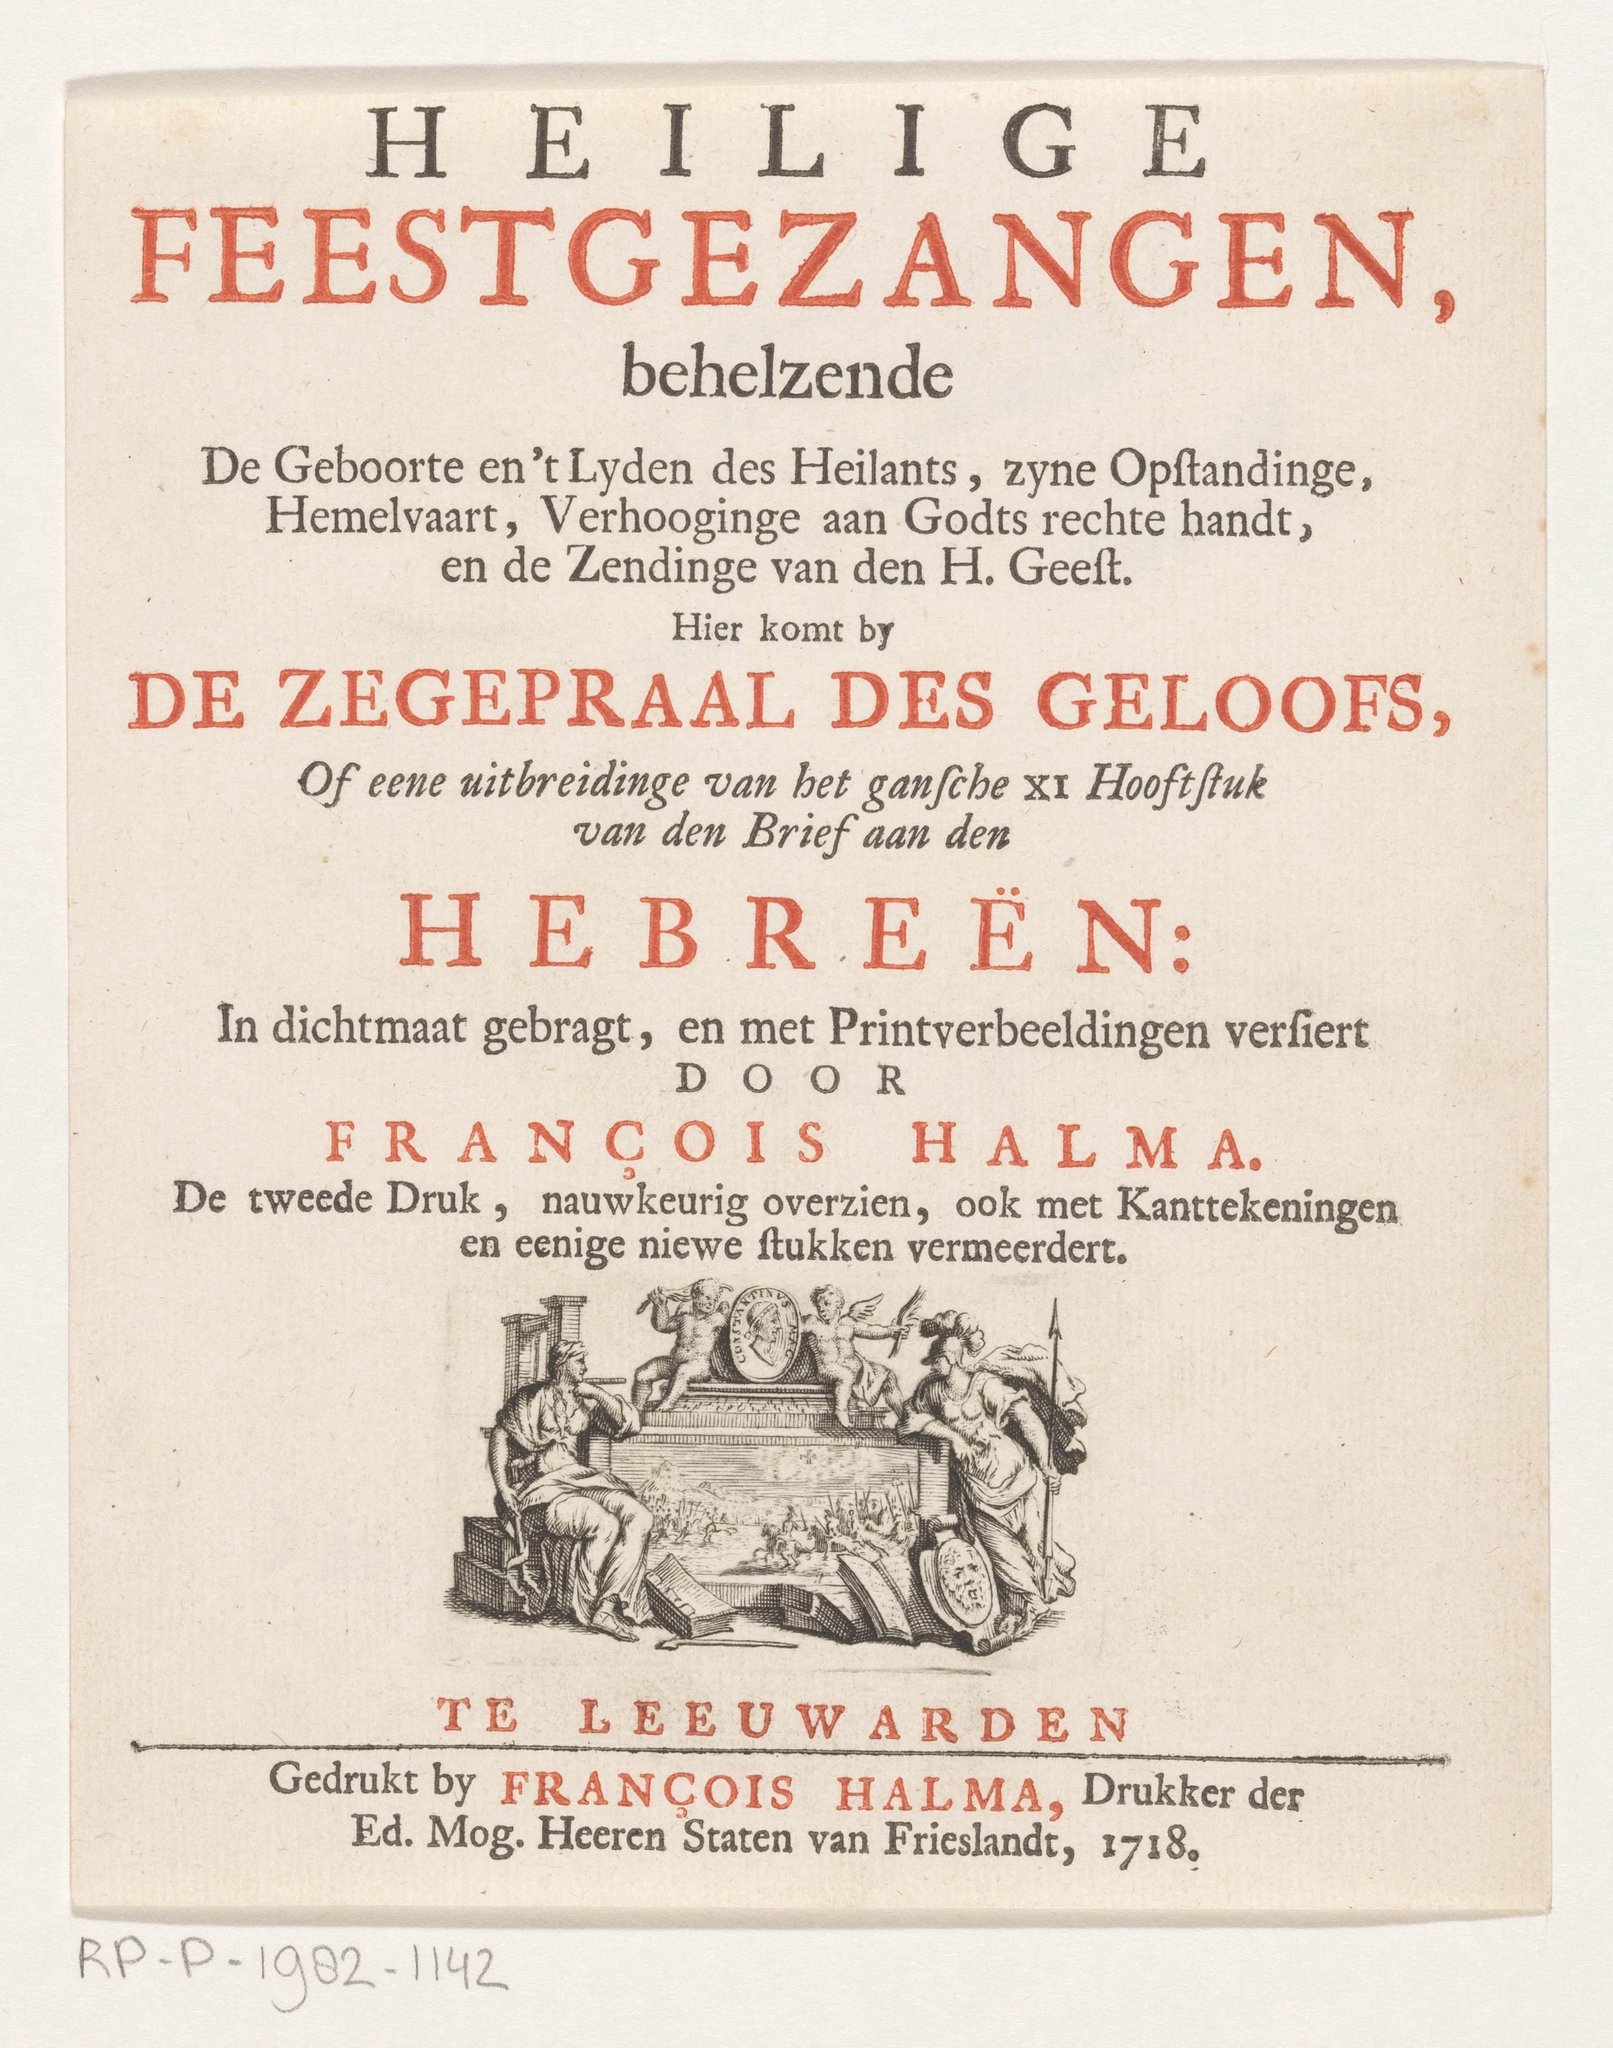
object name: titelblad, titelpagina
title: Titelpagina voor: François Falma, Heilige feestgezangen, 1718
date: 1718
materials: paper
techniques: engraving, letterpress printing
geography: leeuwarden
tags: sitting figure - aa - female human figure, (story of) minerva (pallas, athena), battle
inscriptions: collector's mark: Lugt 2228, collector's mark: Lugt 2760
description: Een zittende allegorische vrouwenfiguur en Minerva met schild flankeren een voorstelling van een veldslag. Boven de voorstelling zitten putti aan weerszijden van een portretmedaillon.